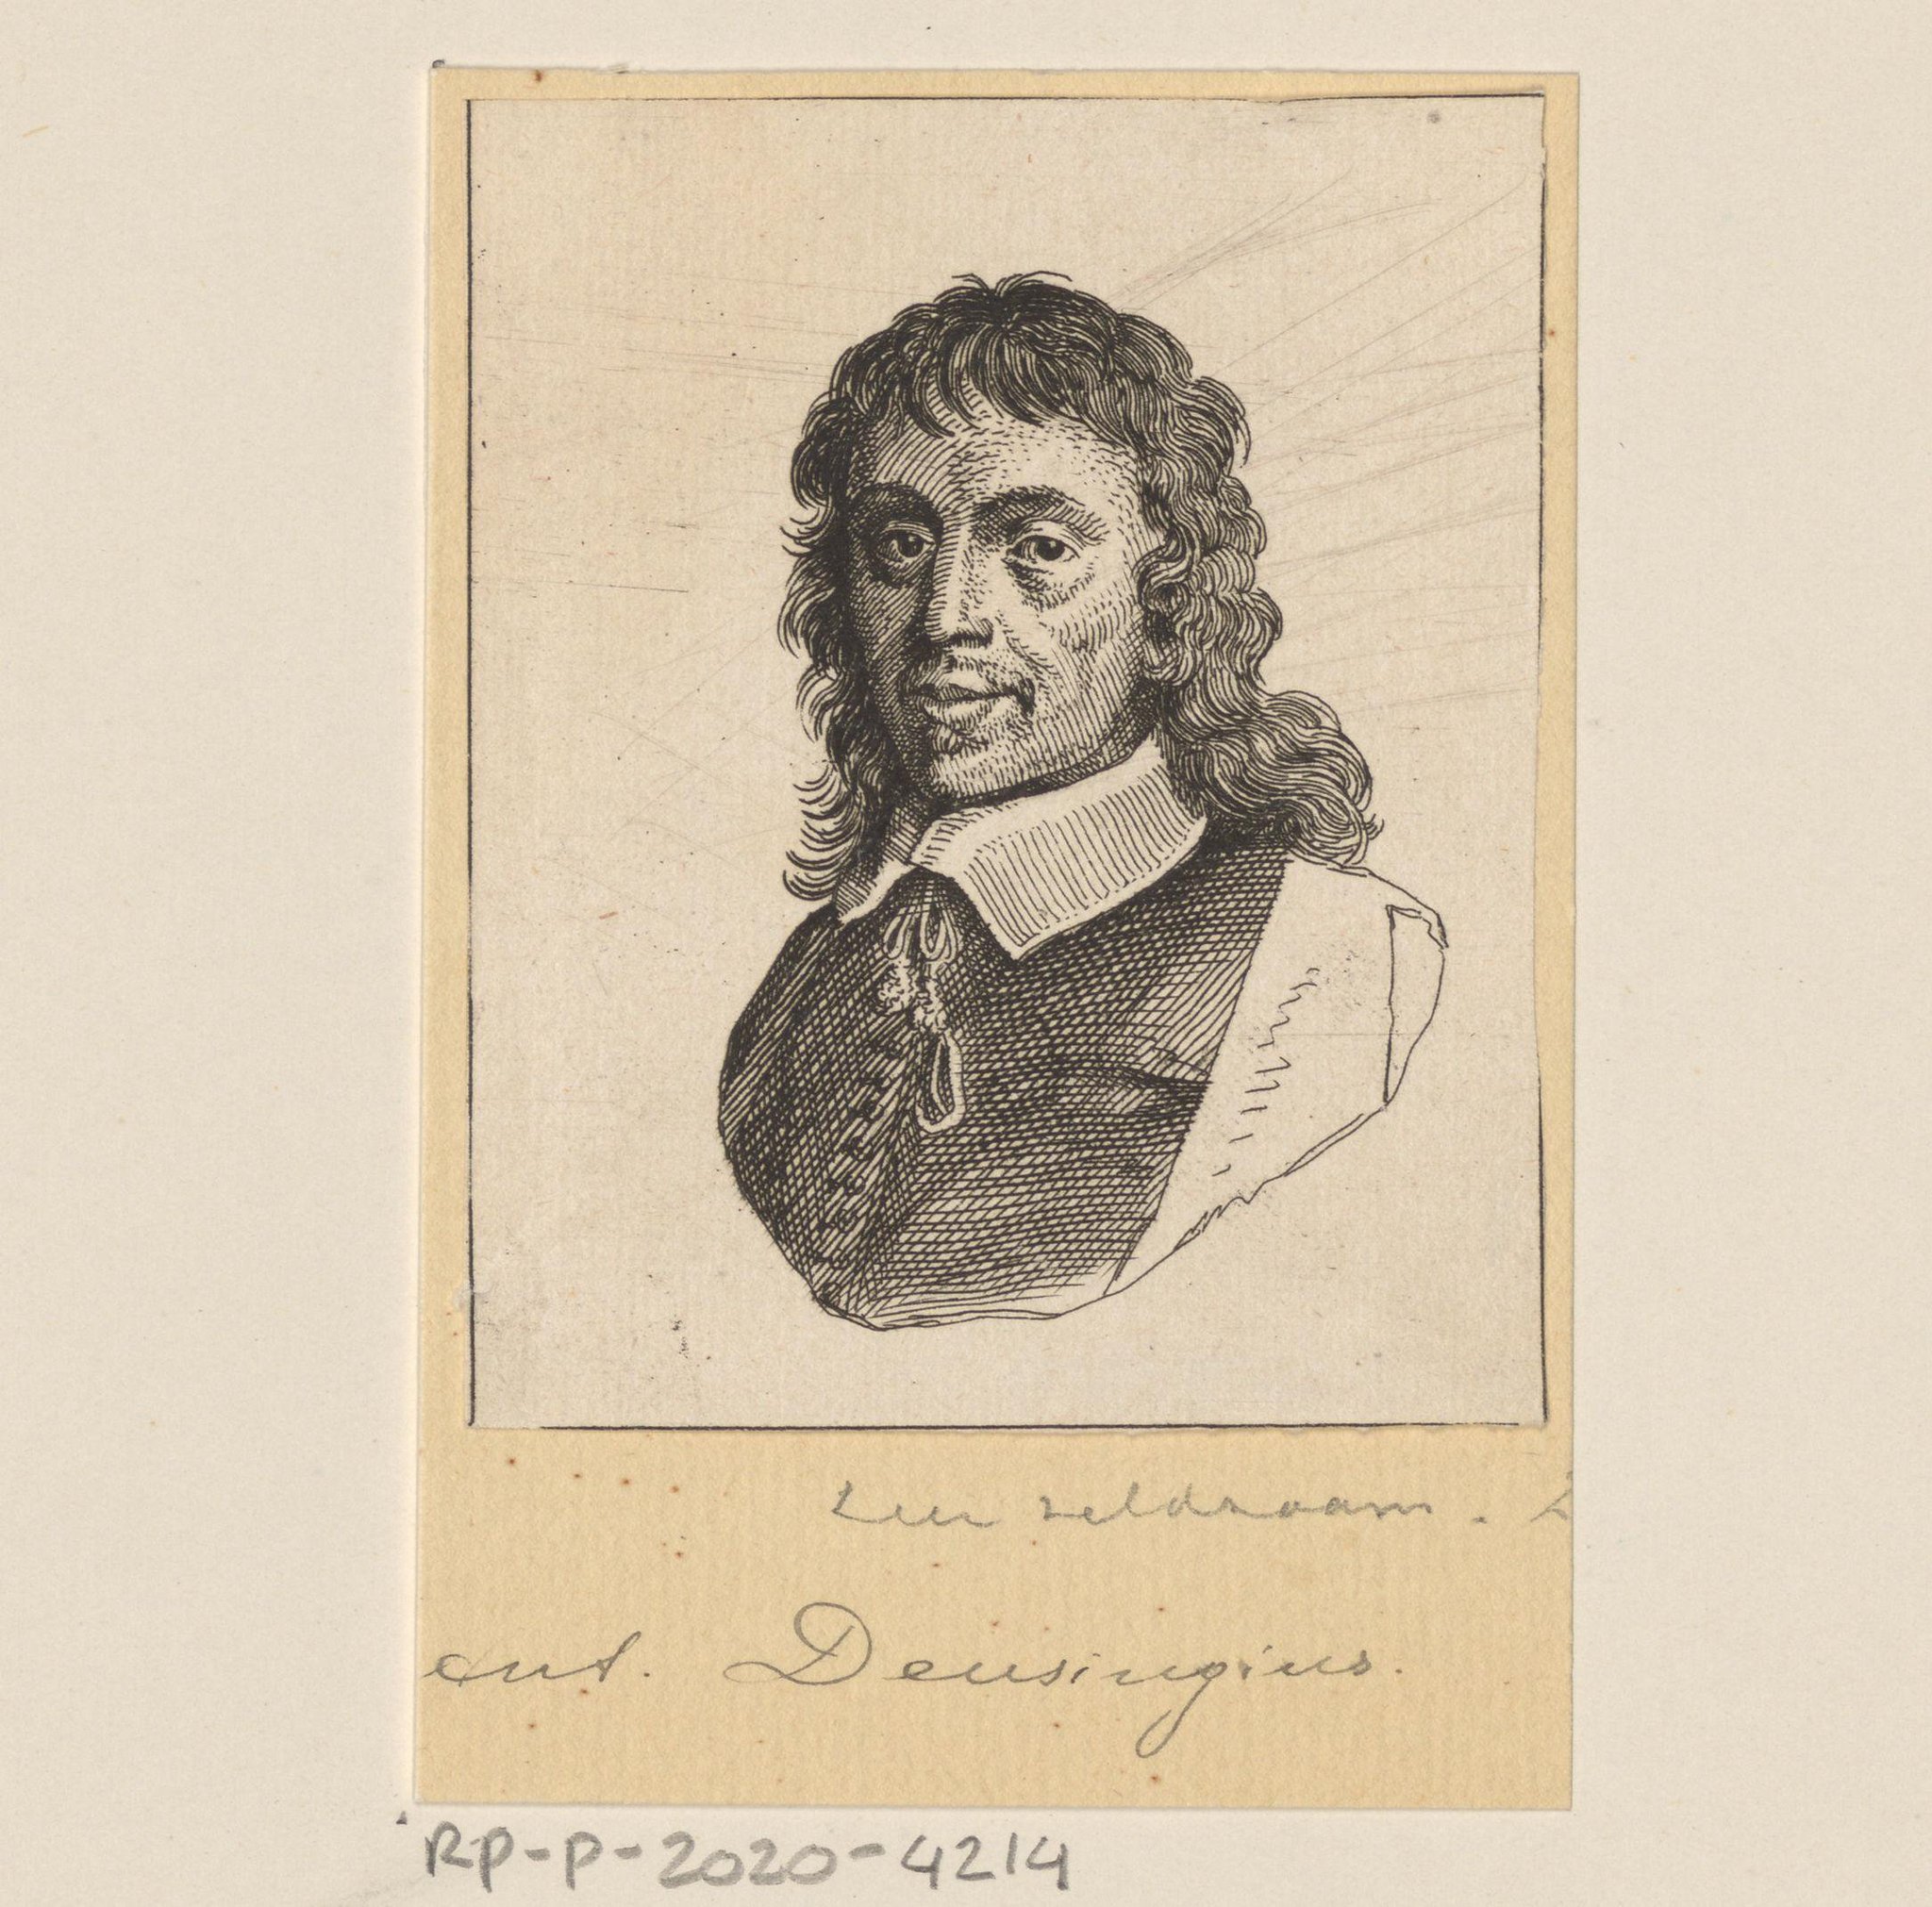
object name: print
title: Portret van Anton Deusing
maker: Anonymous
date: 1650-1749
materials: paper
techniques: etching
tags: historical persons, physician, doctor